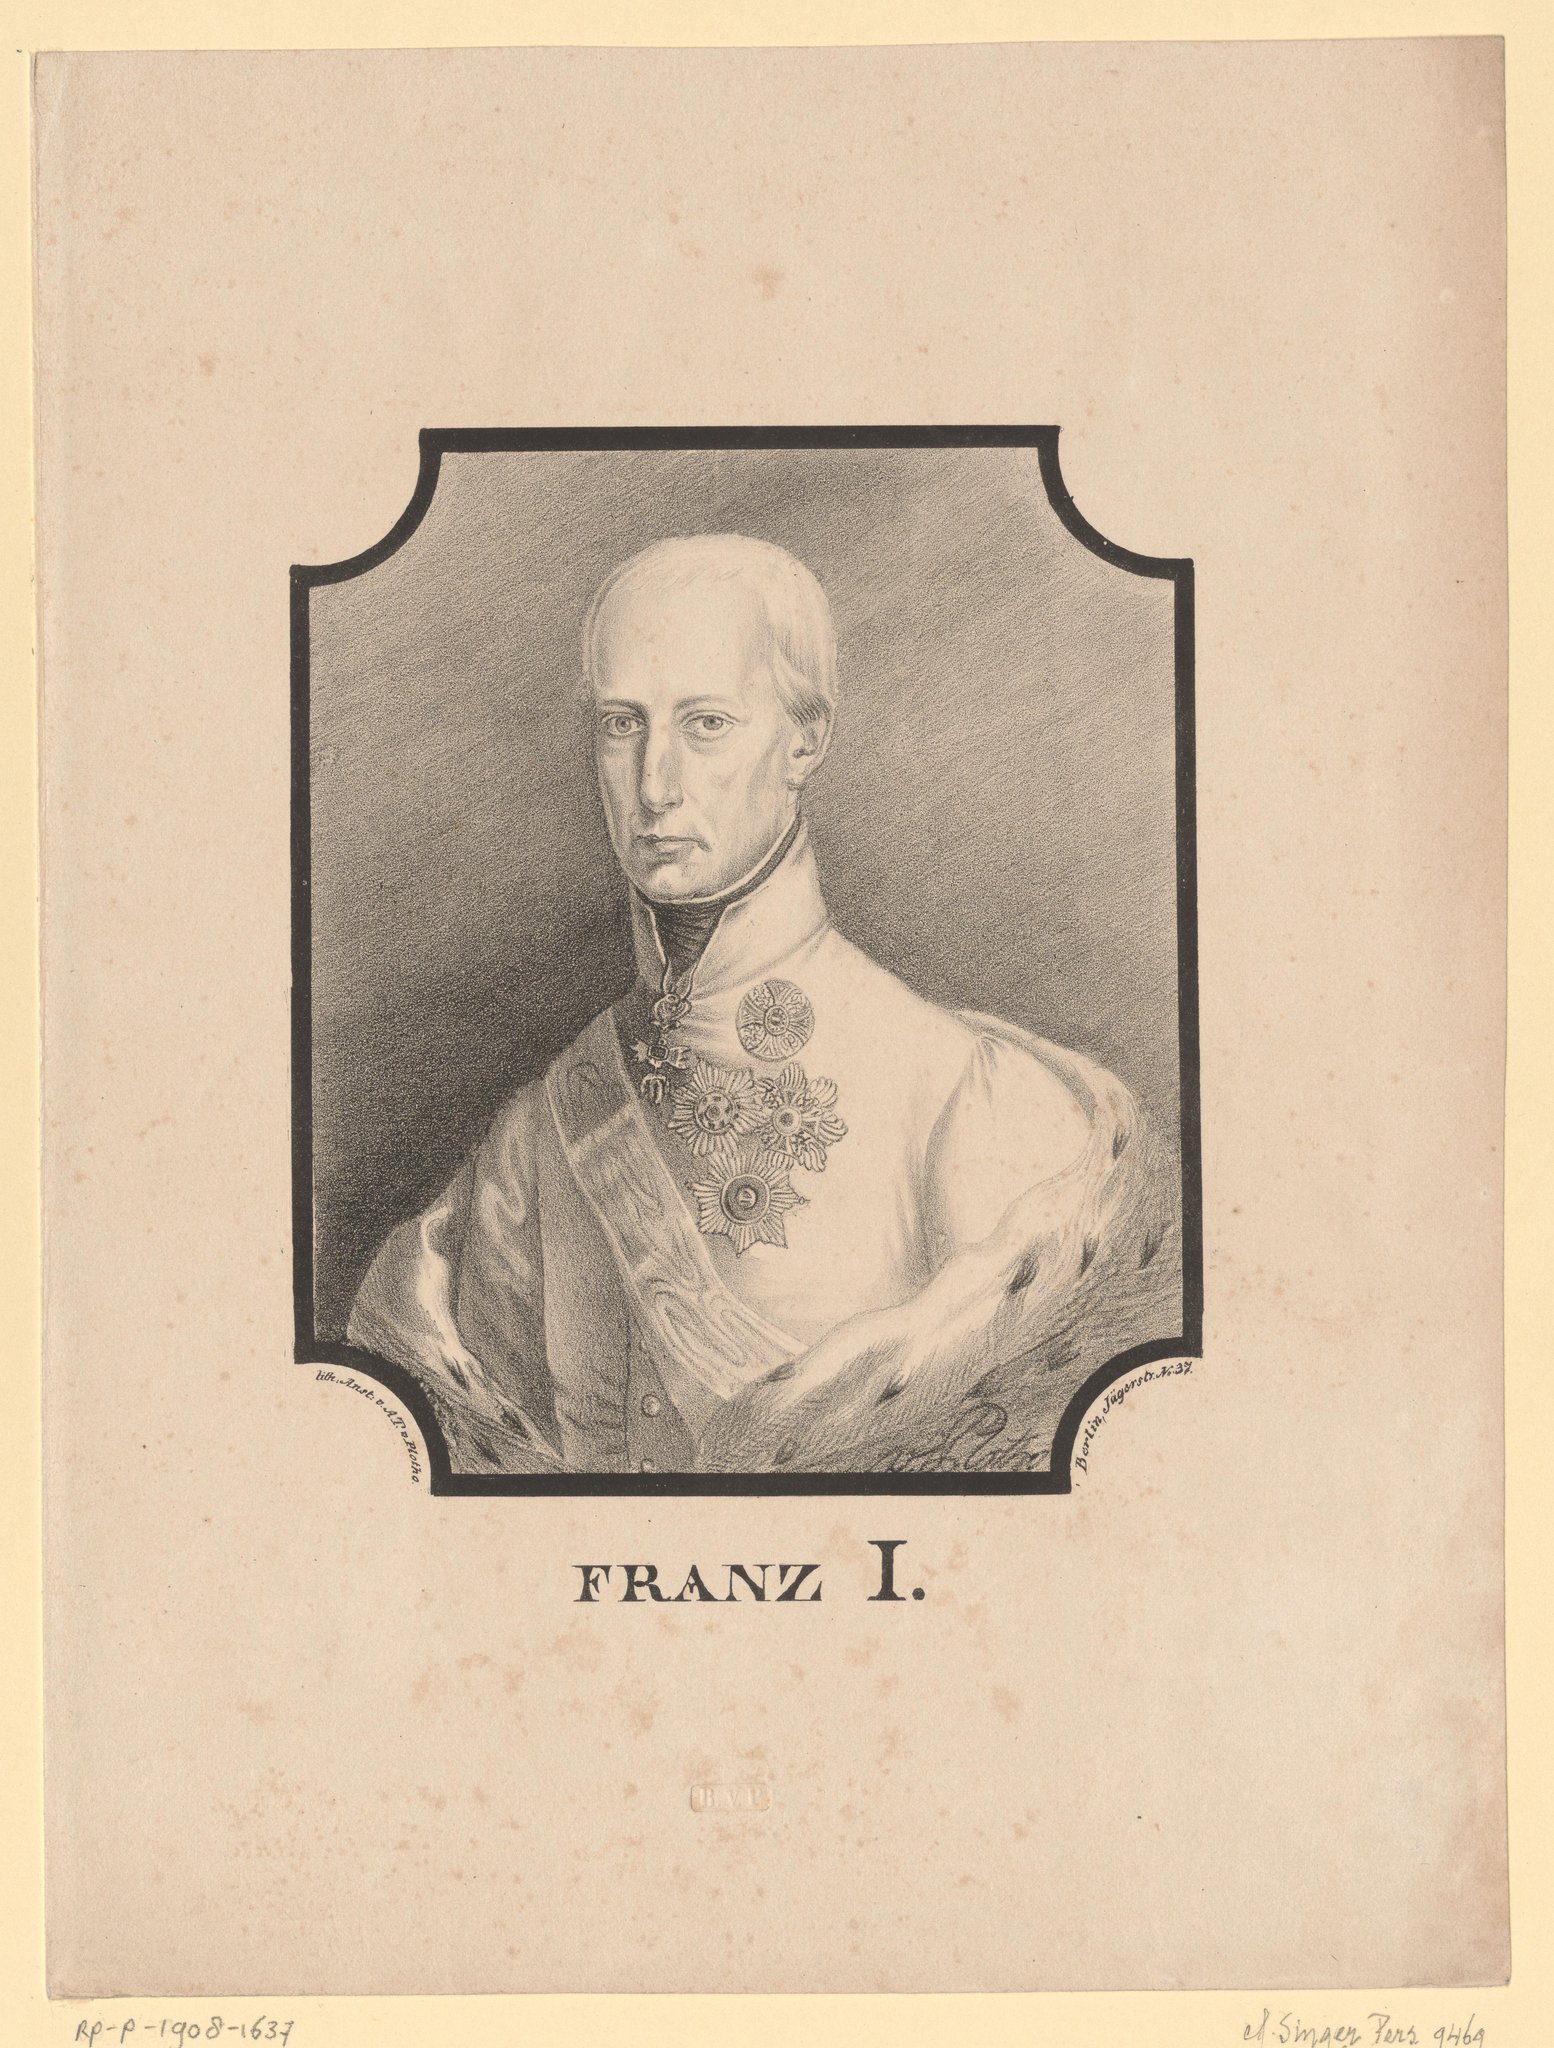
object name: print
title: Portret van Frans I, keizer van Oostenrijk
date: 1804-1850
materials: paper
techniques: lithograph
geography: berlin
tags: vienna, frans ii (rooms-duits keizer), historical persons, emperor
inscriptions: collector's mark: Lugt 2228, check stamp: ‘B.v.P.’